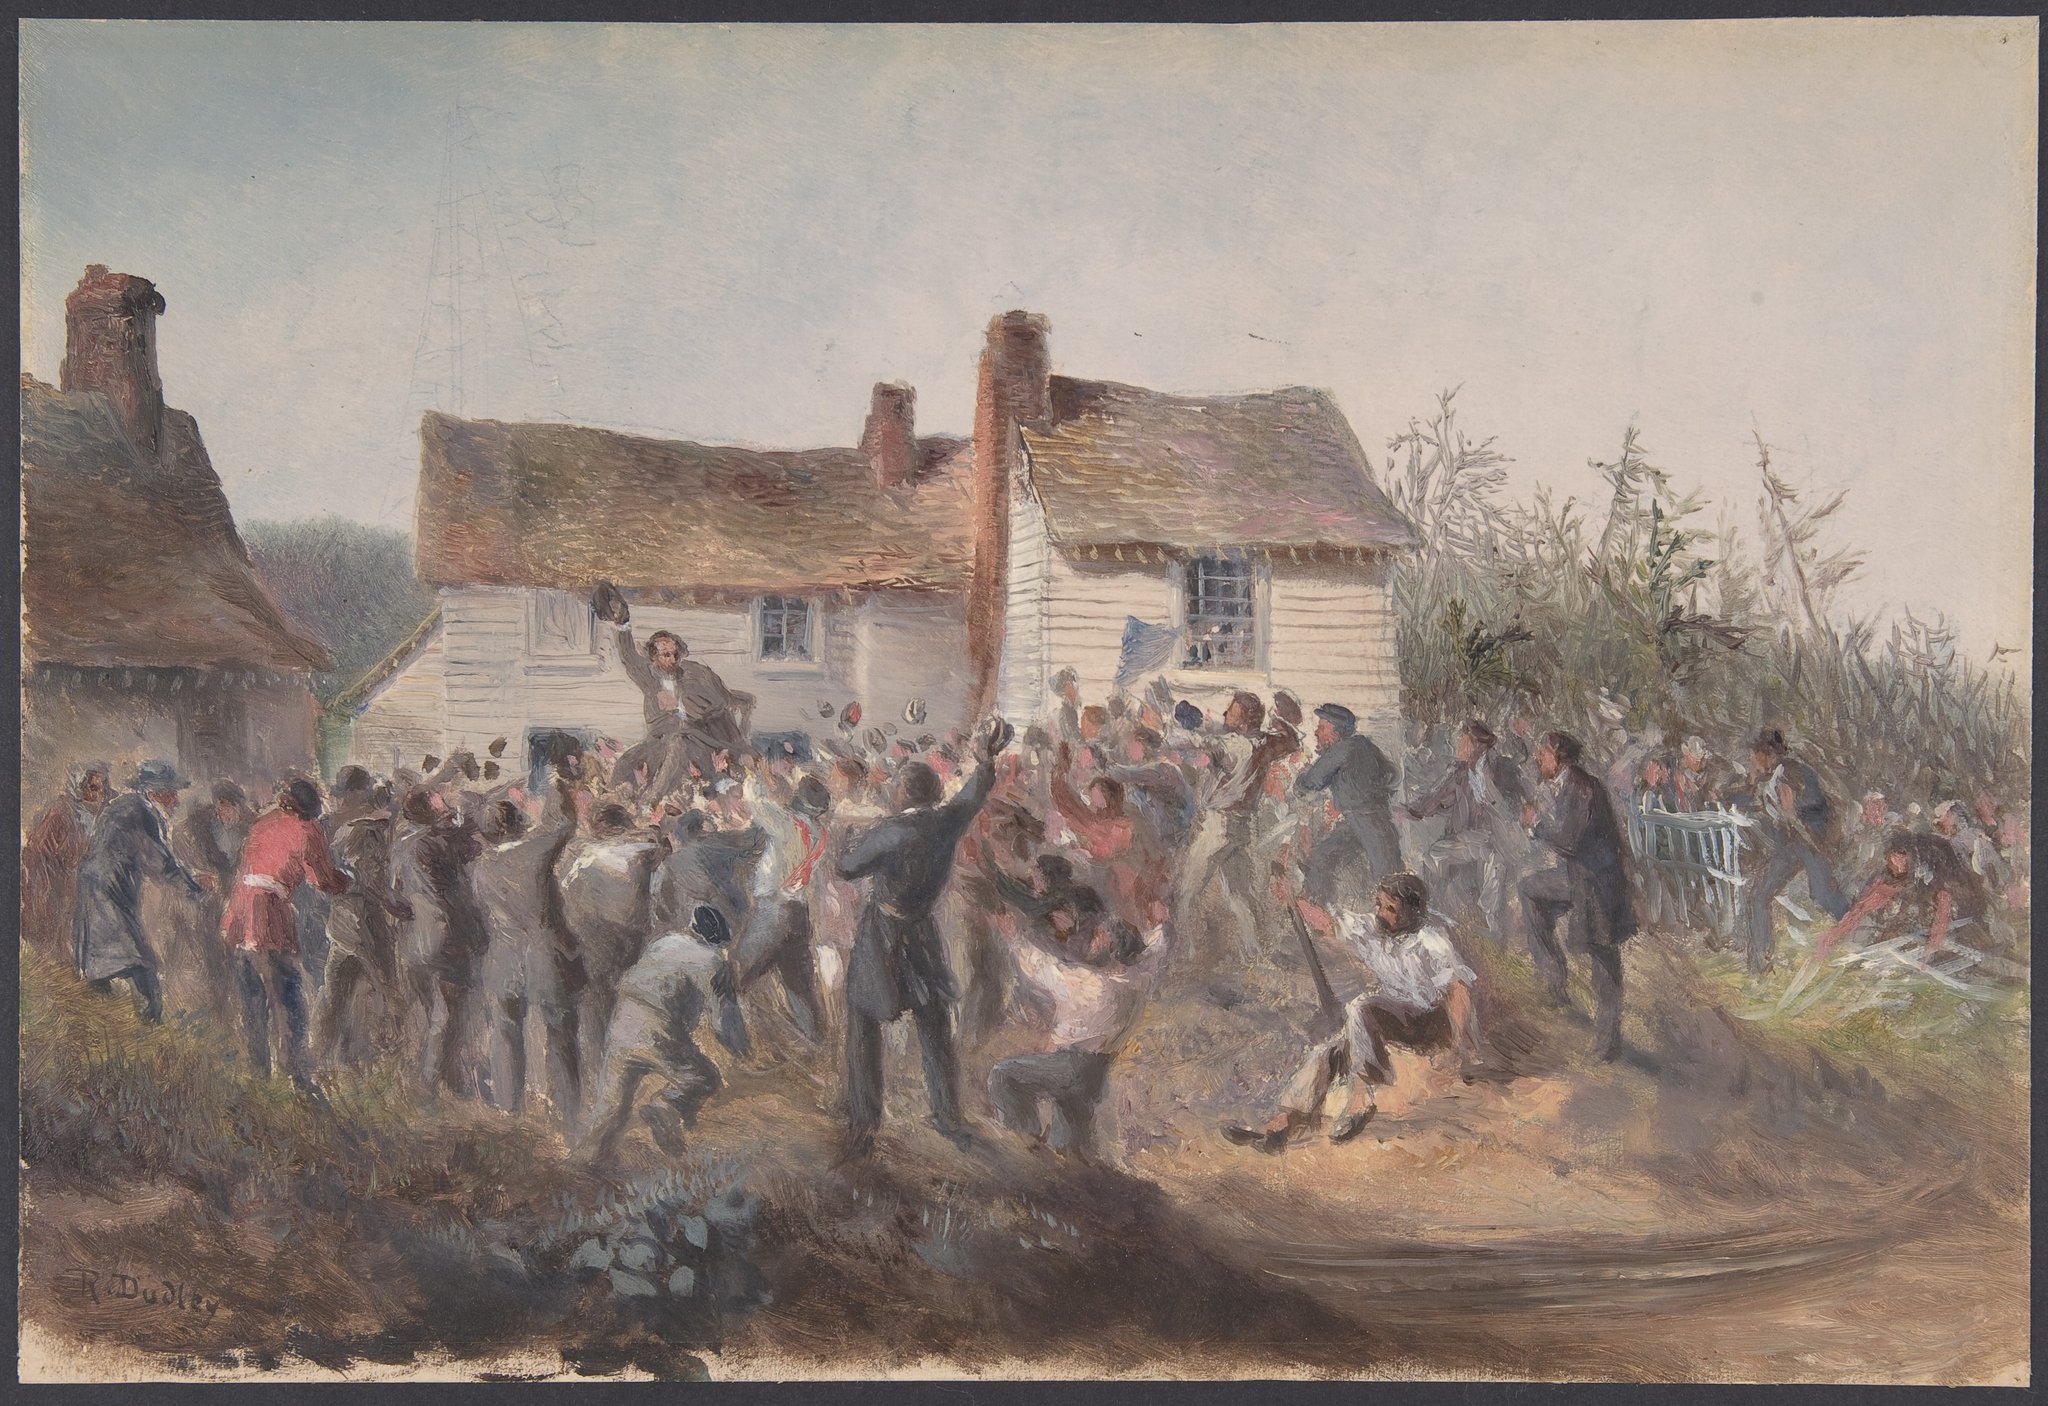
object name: drawing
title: September 8th at Heart's Content, the day of the successful termination of the work of laying, recovering, completing and testing the Atlantic Telegraph Cables of 1865 and 1866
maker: robert charles dudley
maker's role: artist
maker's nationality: british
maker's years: 1826-1909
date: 1866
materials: gouache, graphite, watercolor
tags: men,crowd,transatlantic cable